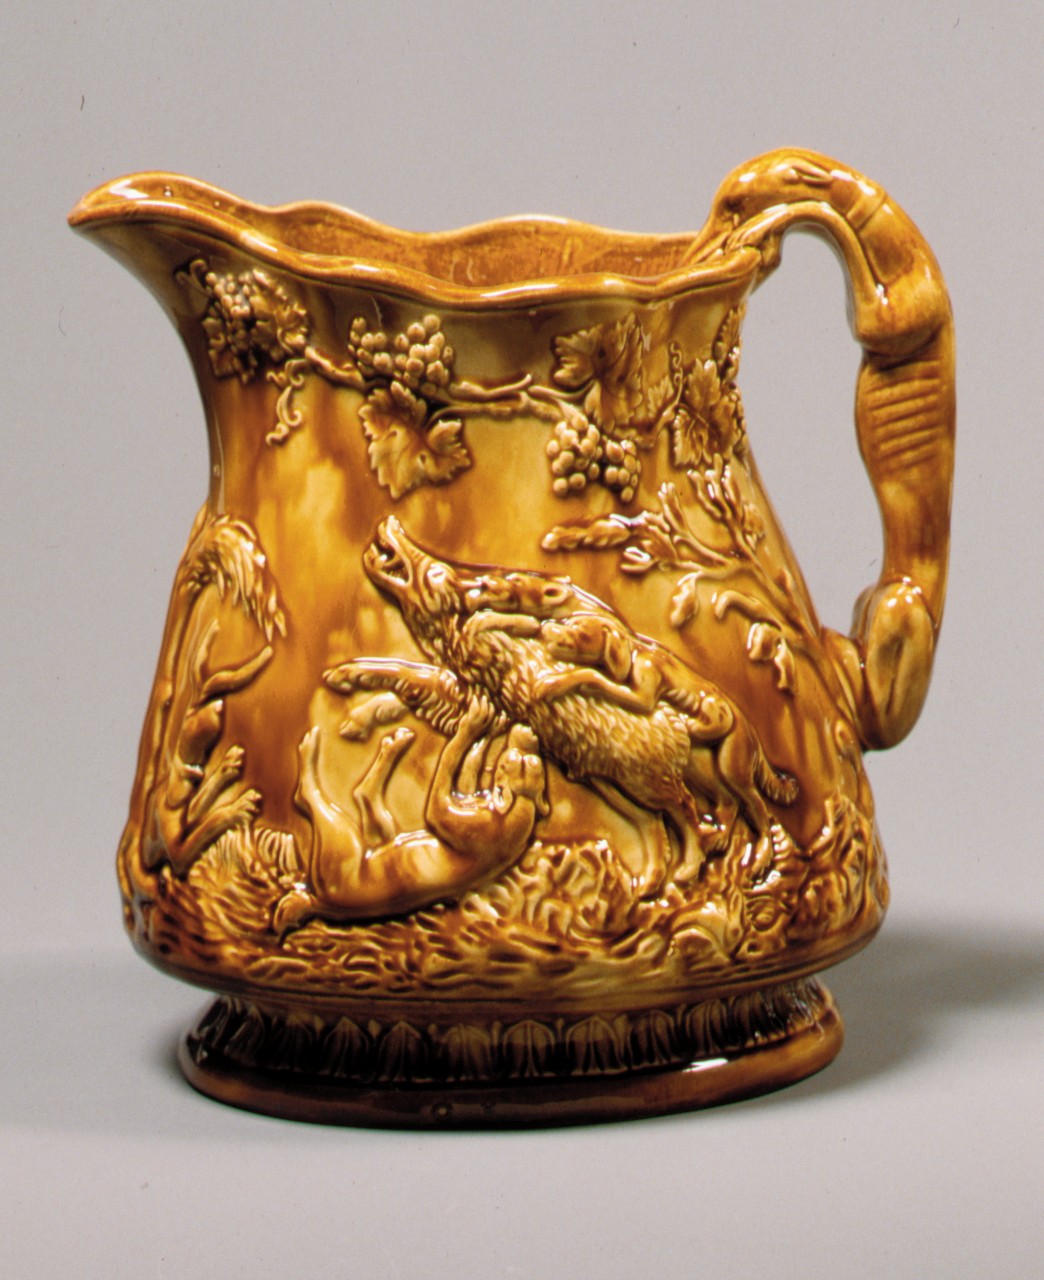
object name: pitcher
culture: american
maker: e. & w. bennett pottery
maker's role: manufacturer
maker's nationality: american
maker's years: 1847-1857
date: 1850-1856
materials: earthenware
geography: united states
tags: grapes,hunting,boars,dogs